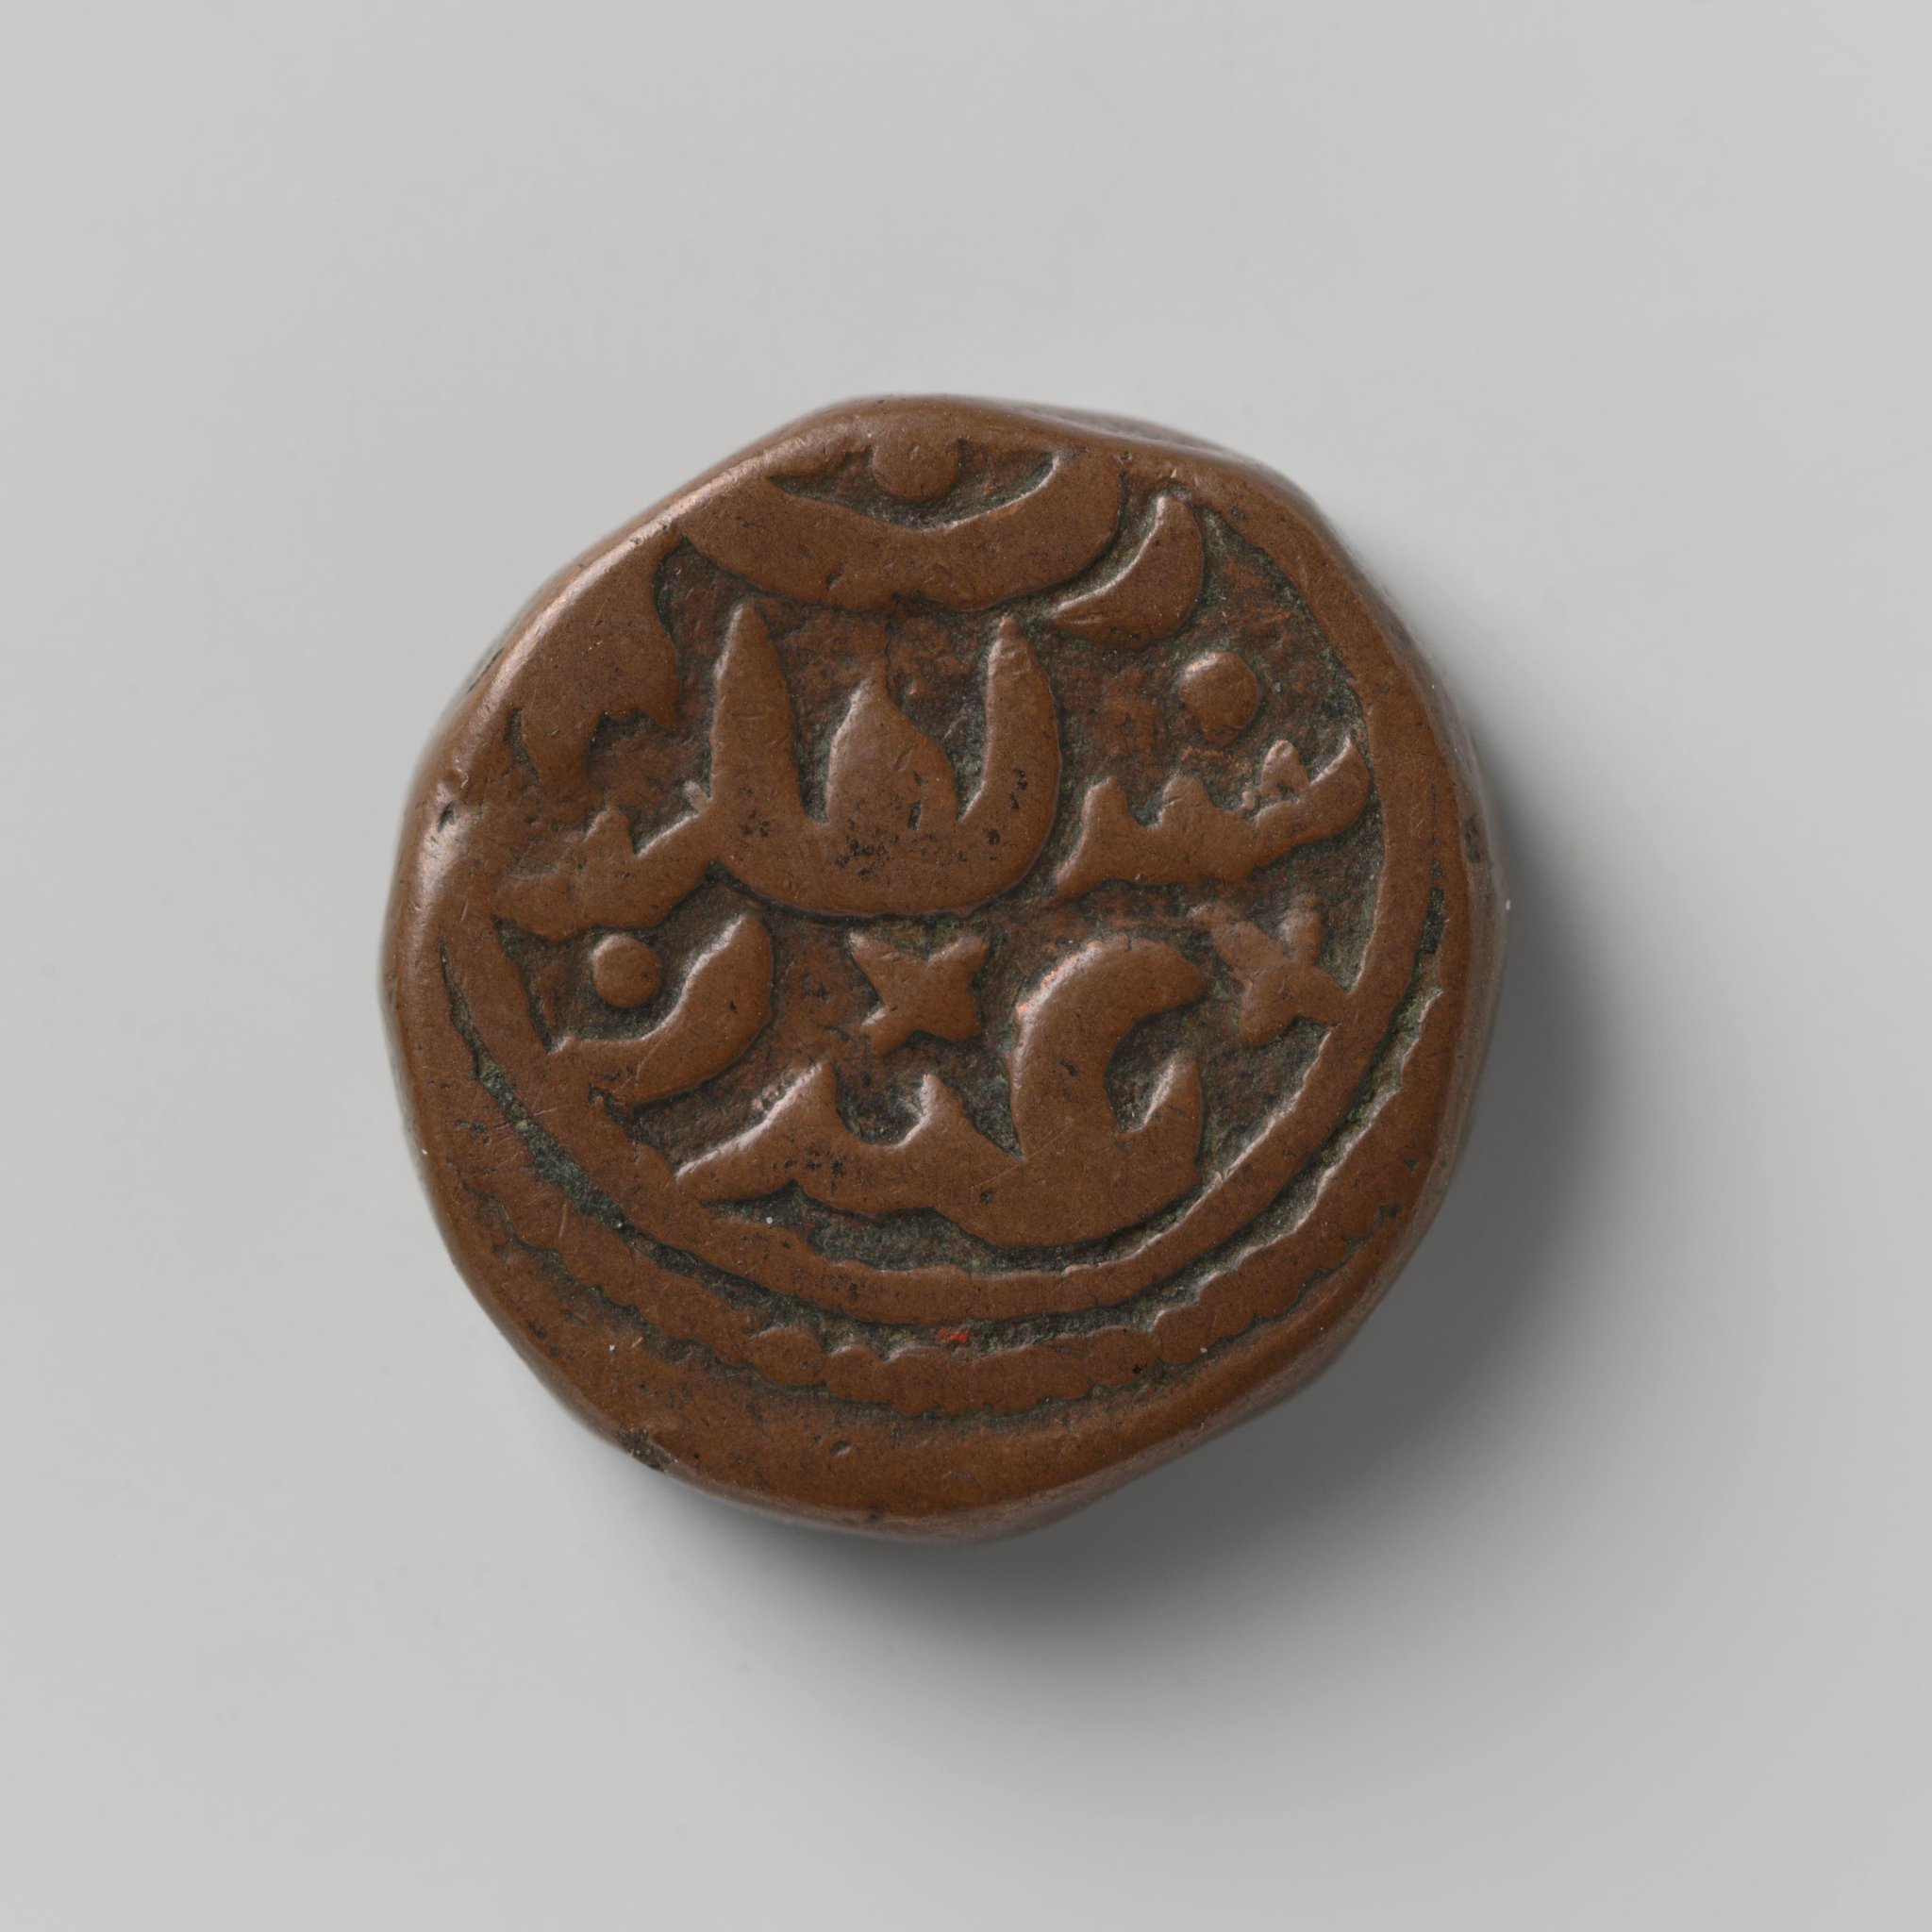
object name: coin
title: VOC, Paliakate, Voor-Indië, 10 kas of stuiver voor Ceylon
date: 1650-1700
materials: copper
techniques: striking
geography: paliacatta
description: Koperen munt. Voorzijde: monogram van de VOC, waarboven waarde-aanduiding X. Keerzijde: drieregelig opschrift in Arabische lettertekens. Gladde rand.